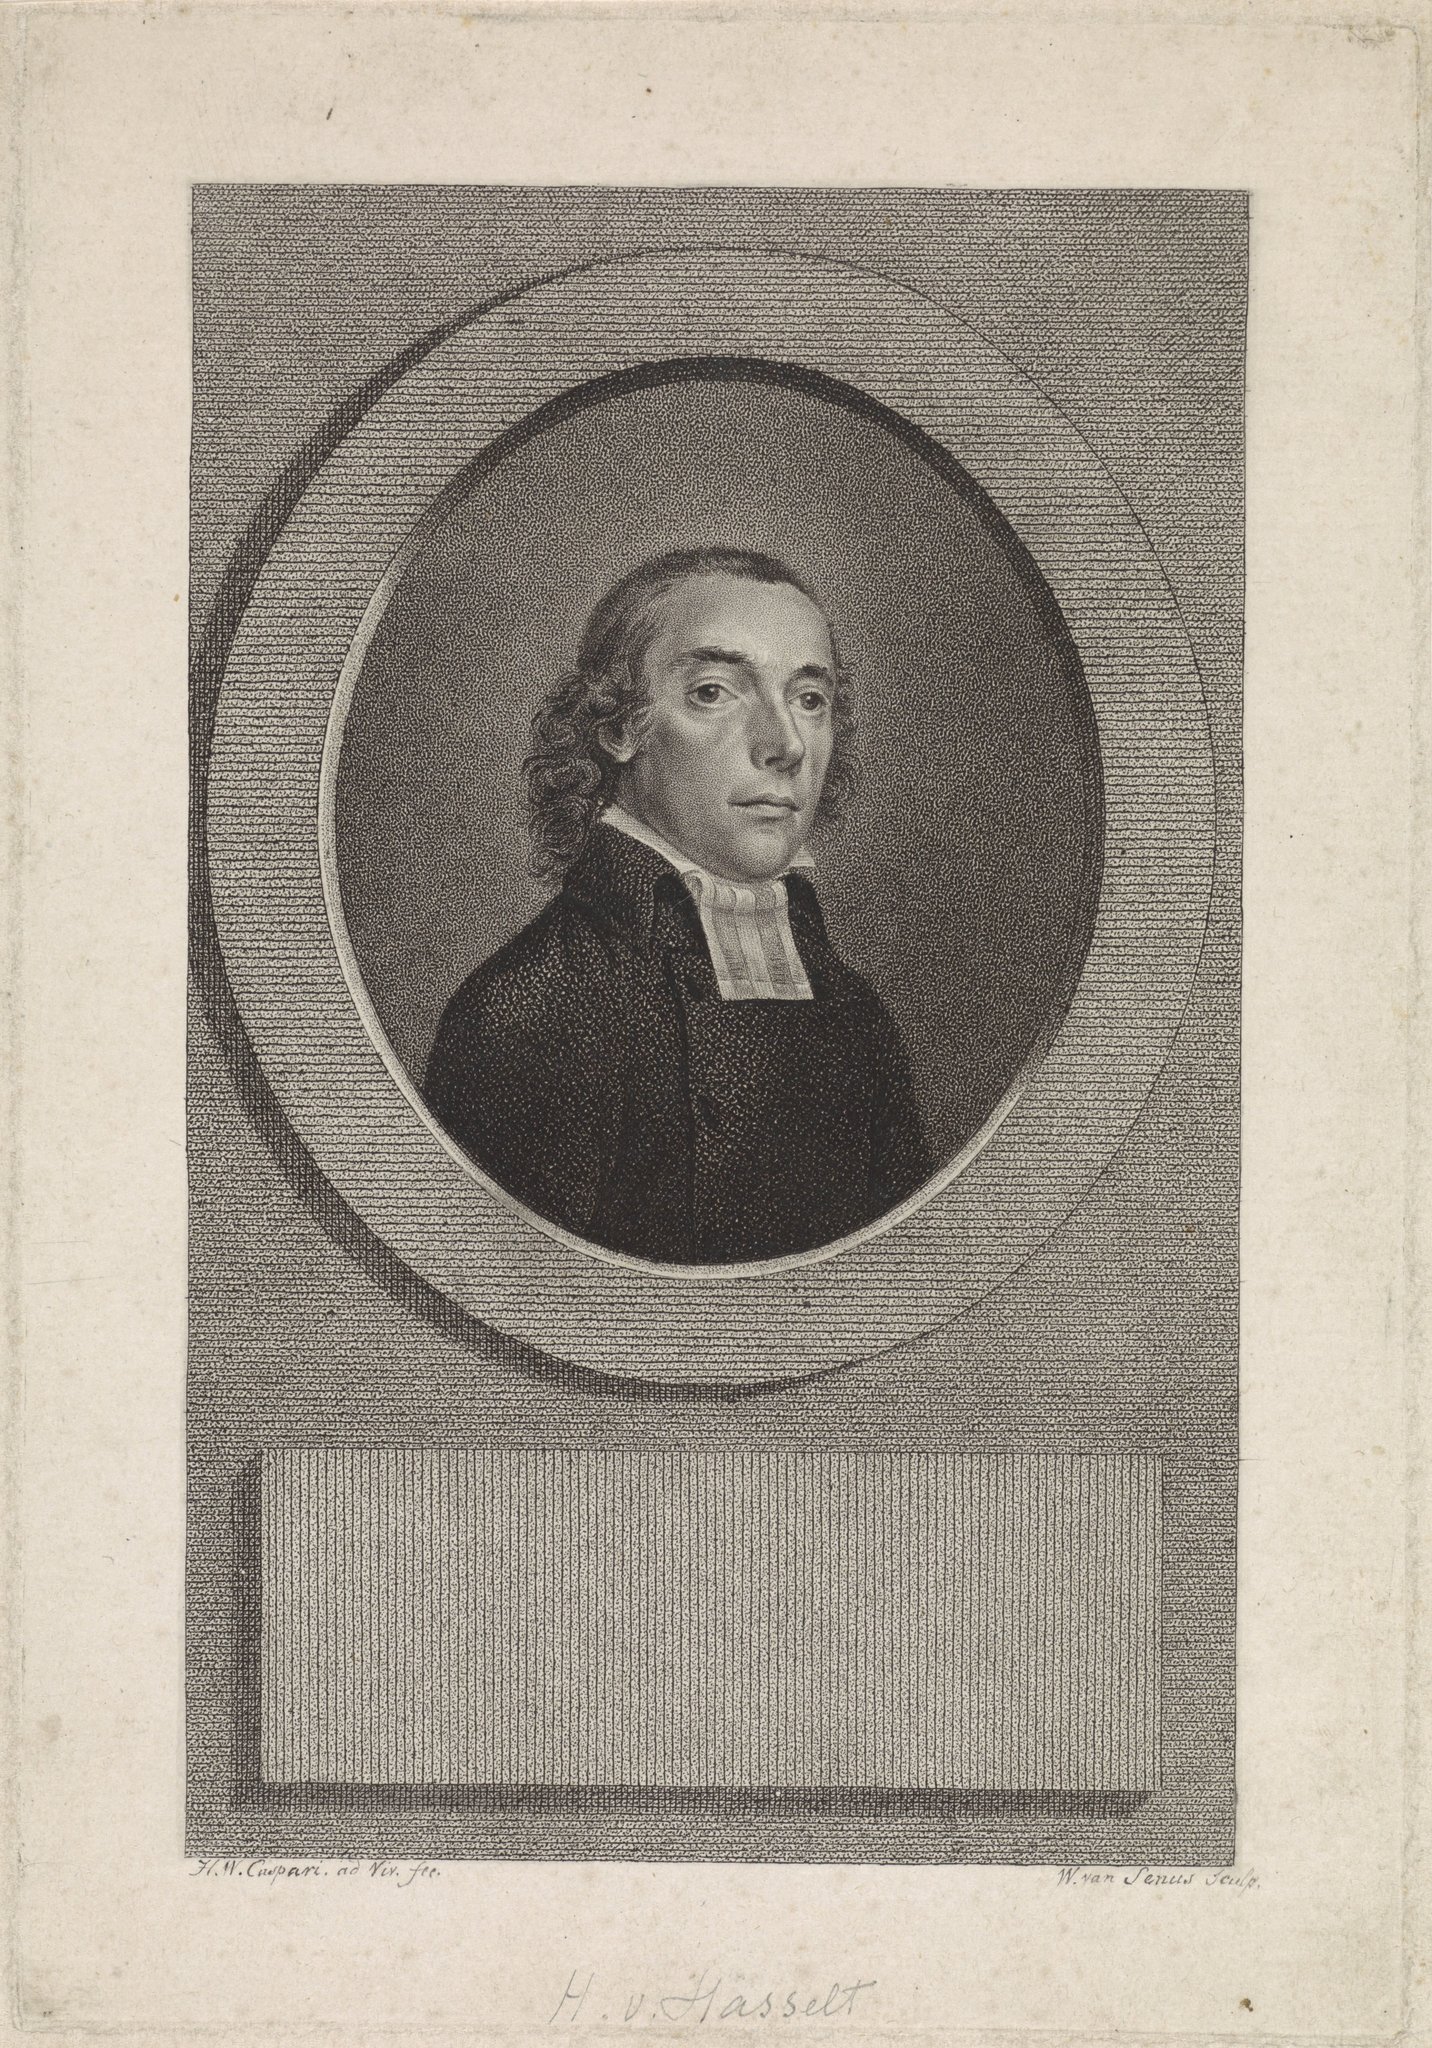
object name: print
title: Portret van Hermanus van Hasselt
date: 1796-1851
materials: paper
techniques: engraving, etching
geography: netherlands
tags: hillegom, predikant, hermanus van hasselt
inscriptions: collector's mark: Lugt 2228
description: Portret van de predikant Hermanus van Hasselt.